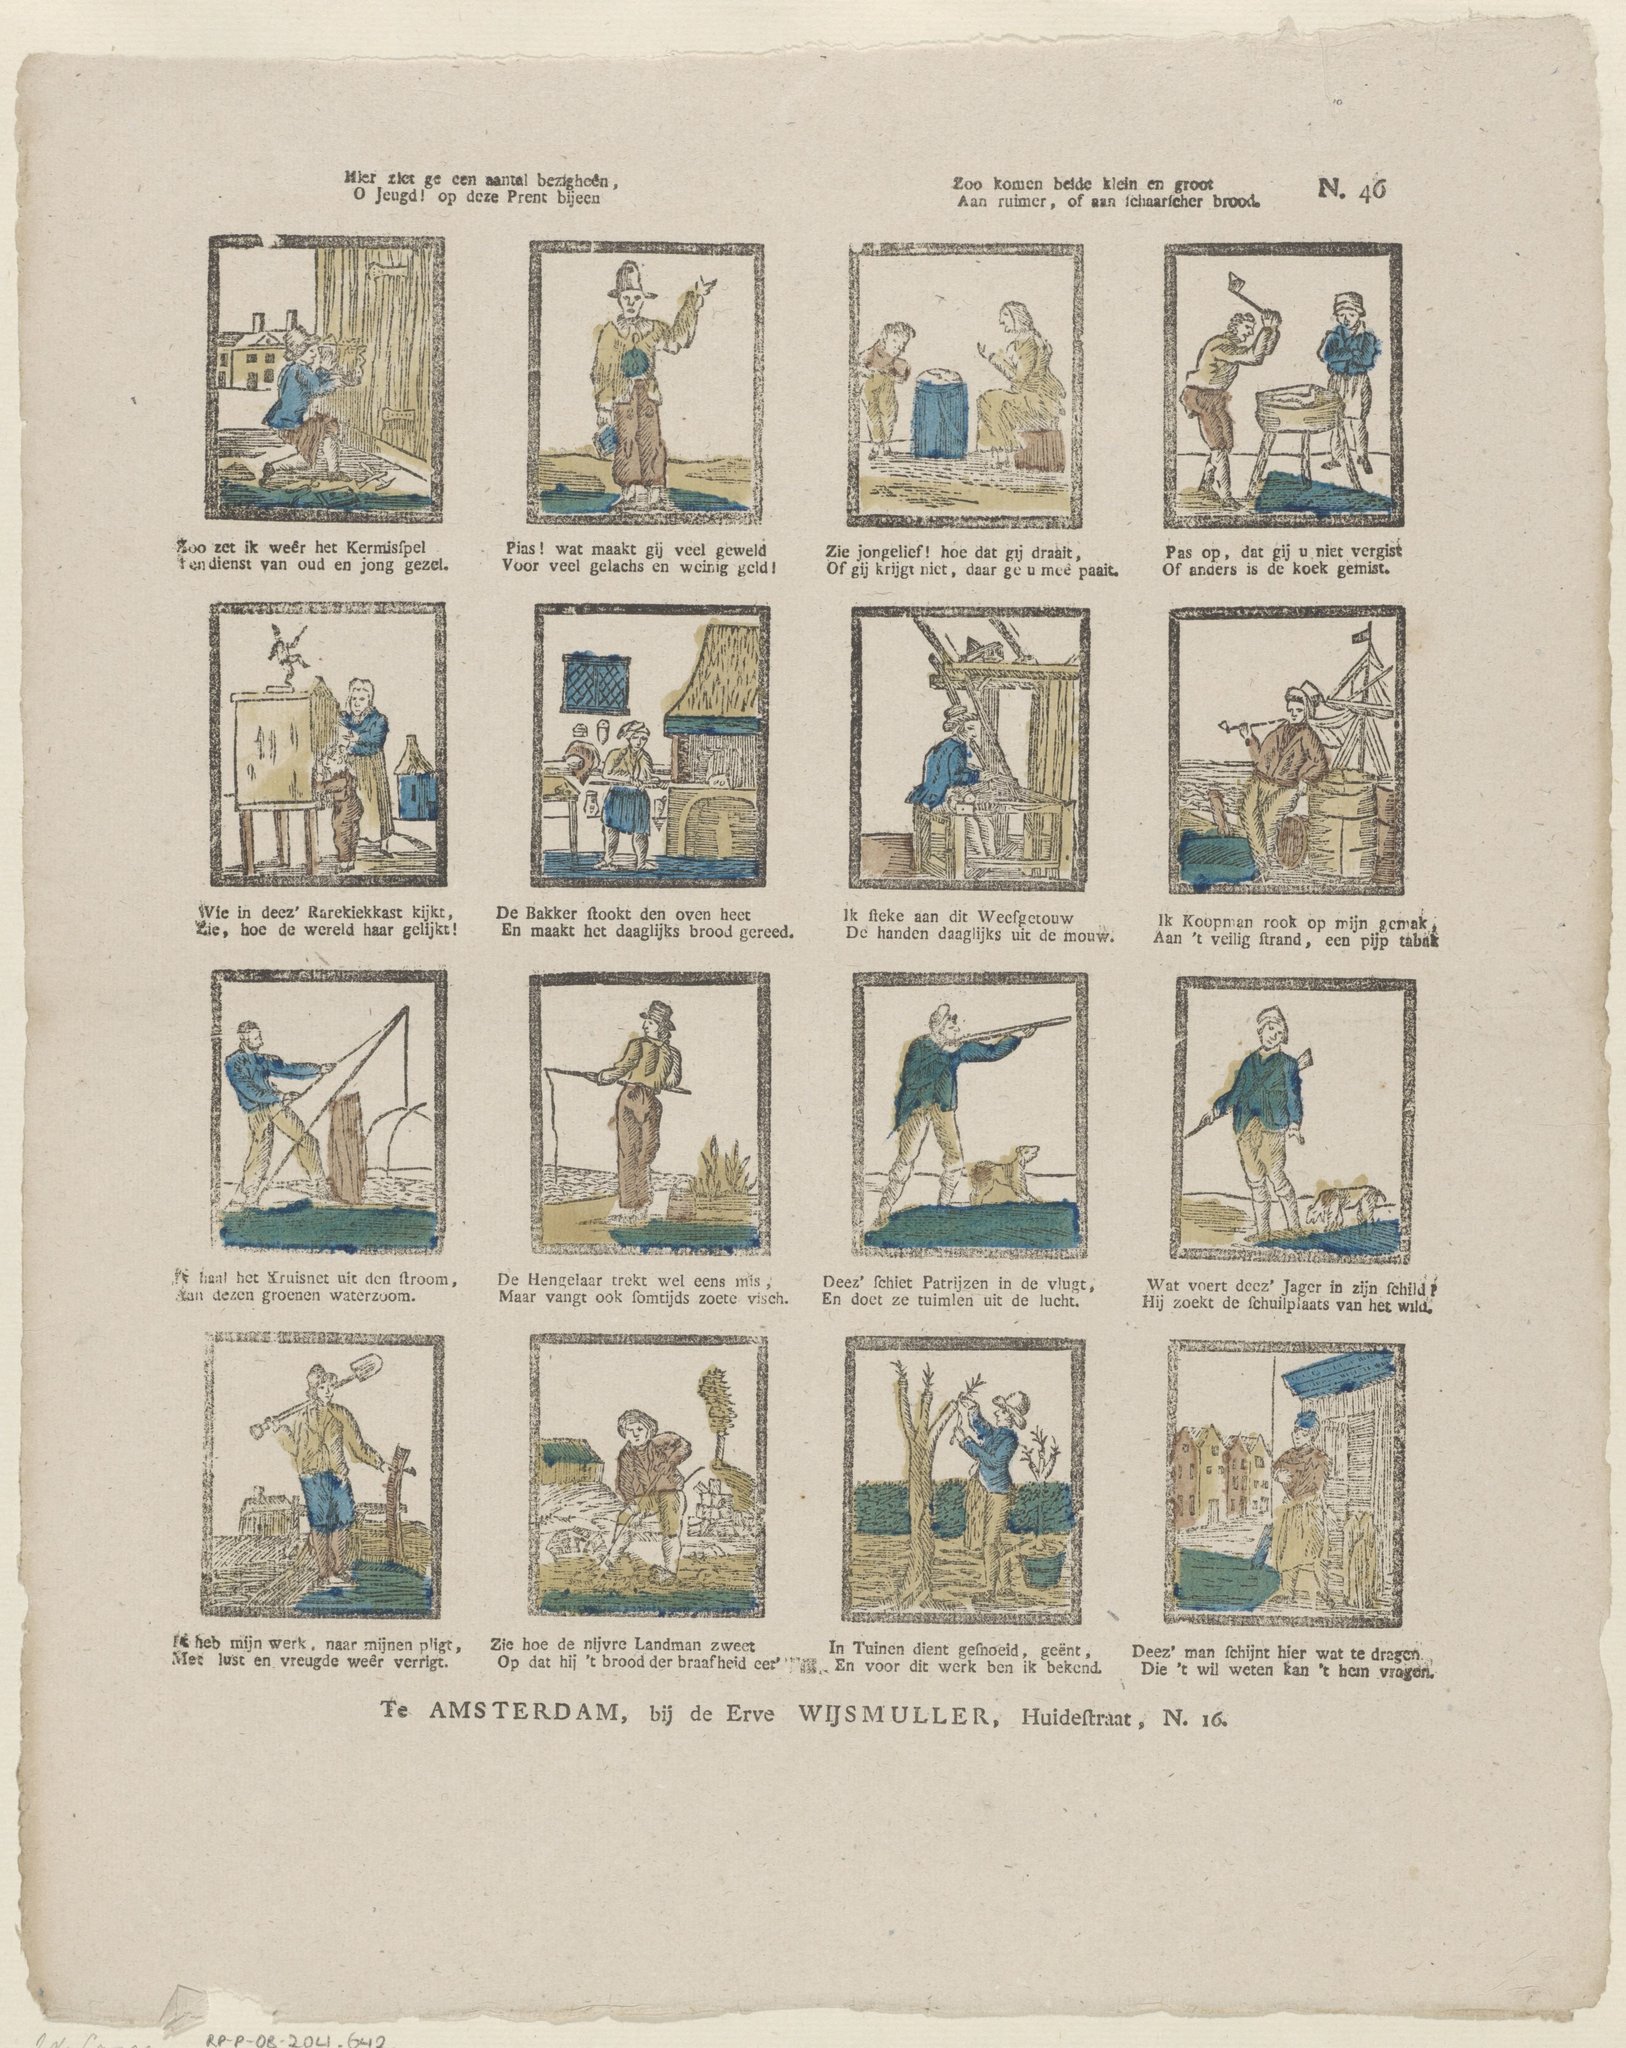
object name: popular print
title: Hier ziet ge een aantal bezigheên, / O jeugd! op deze prent bijeen / Zoo komen beide klein en groot / Aan ruimer, of aan schaarscher brood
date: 1828-1849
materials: paper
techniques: colour, letterpress printing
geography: amsterdam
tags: craft-production, skilled handiwork, human types, hunter, working class, labourers, fishing (sports), crafts and industries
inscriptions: collector's mark: Lugt 2760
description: Blad met 16 voorstellingen van verschillende beroepen en bezigheden, zoals een bakker, een wever en een koopman. Onder elke afbeelding een tweeregelig vers. Genummerd rechtsboven: N. 46.